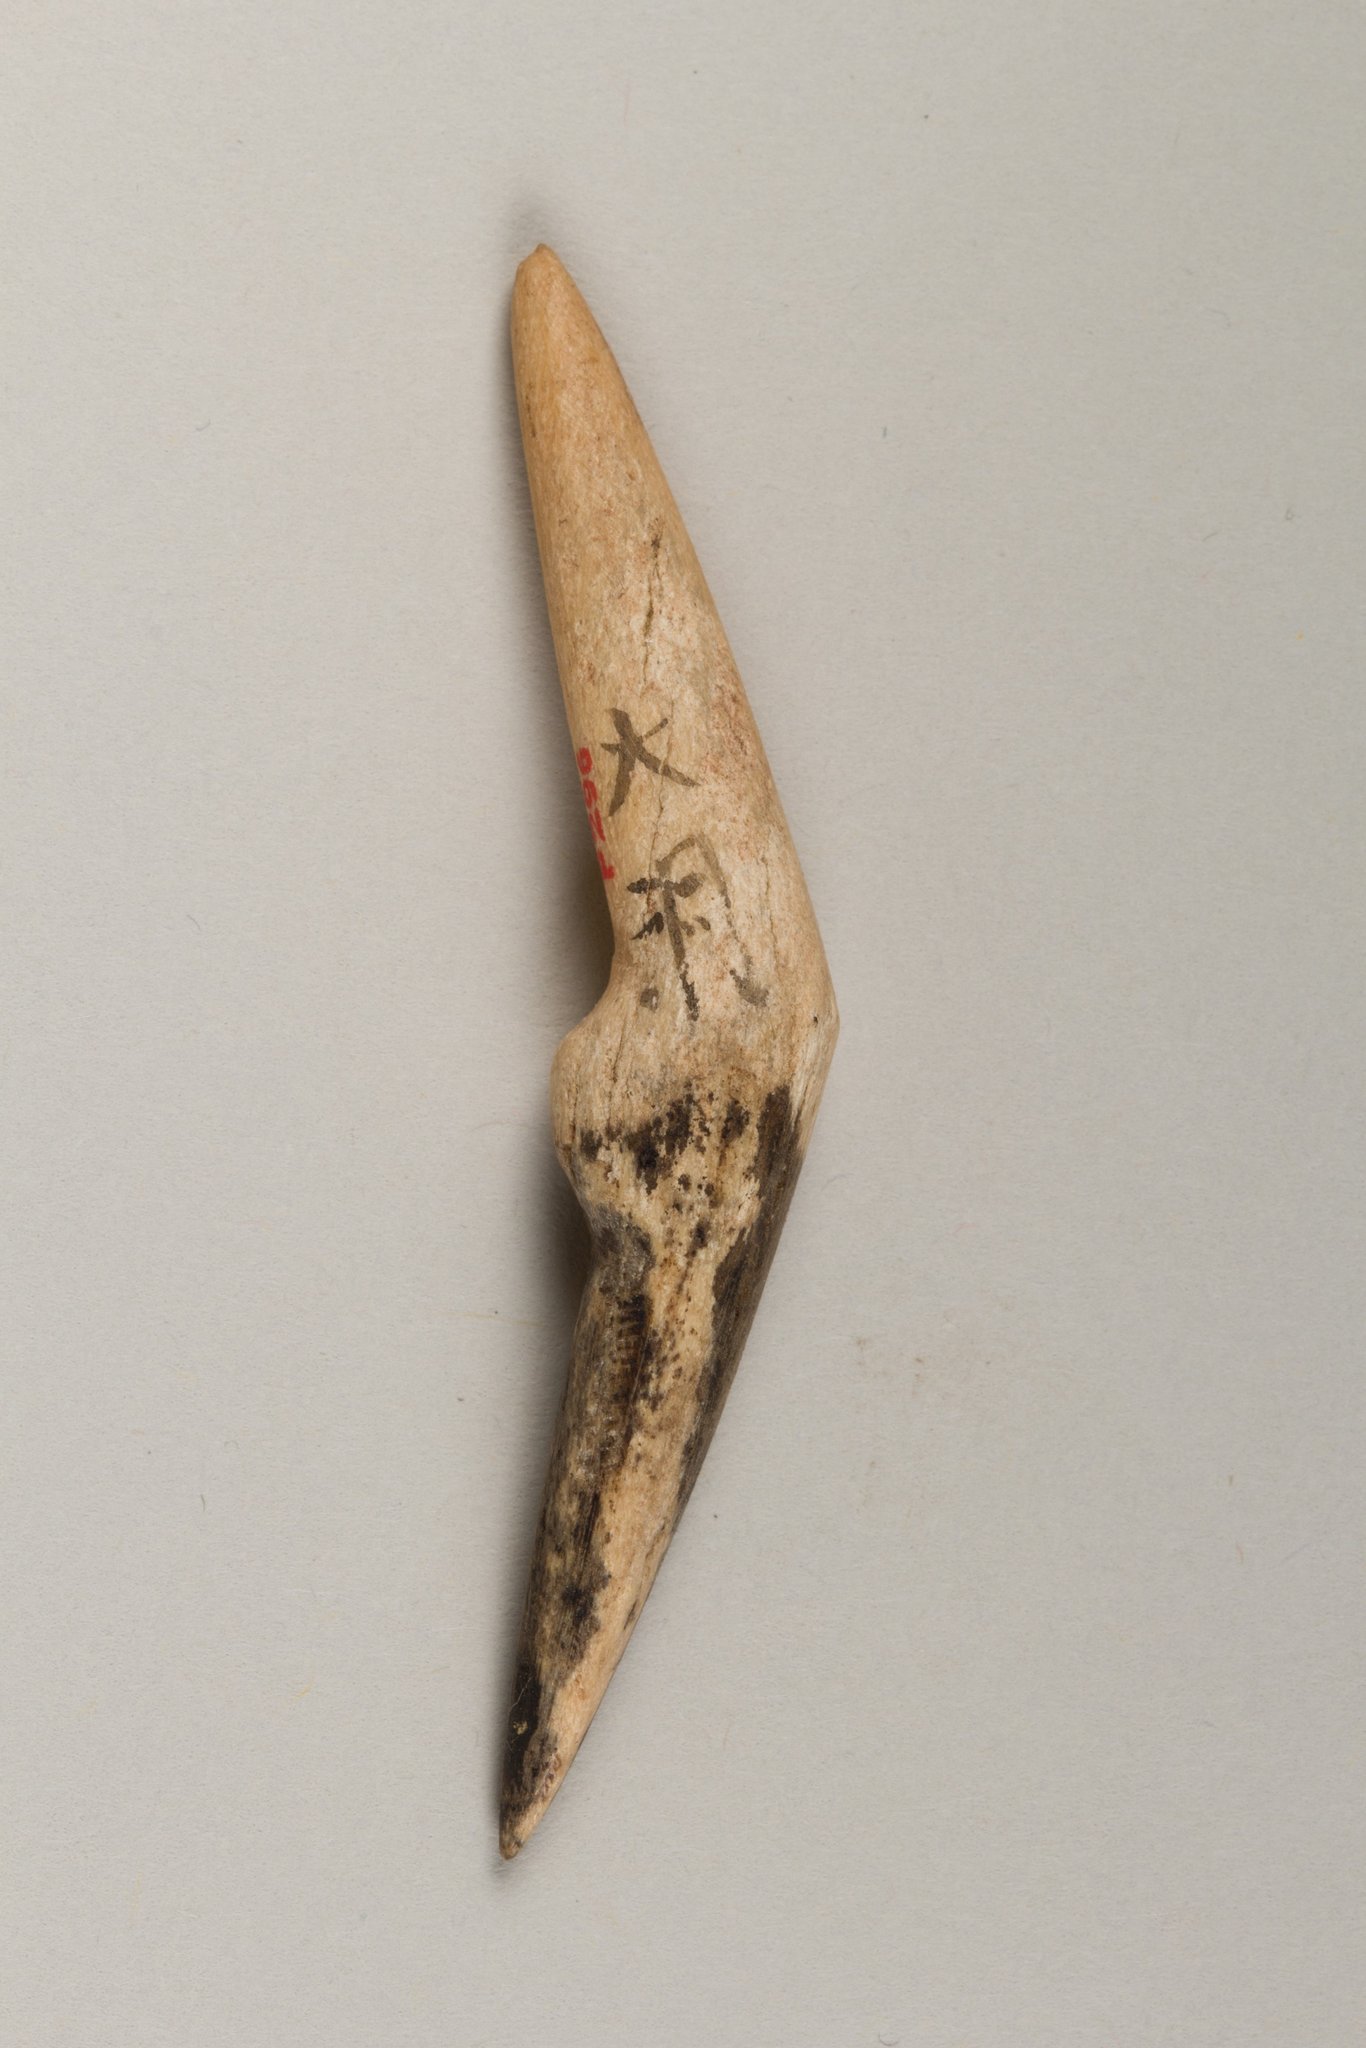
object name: body ornament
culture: japanese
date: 1000-300 BCE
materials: bone